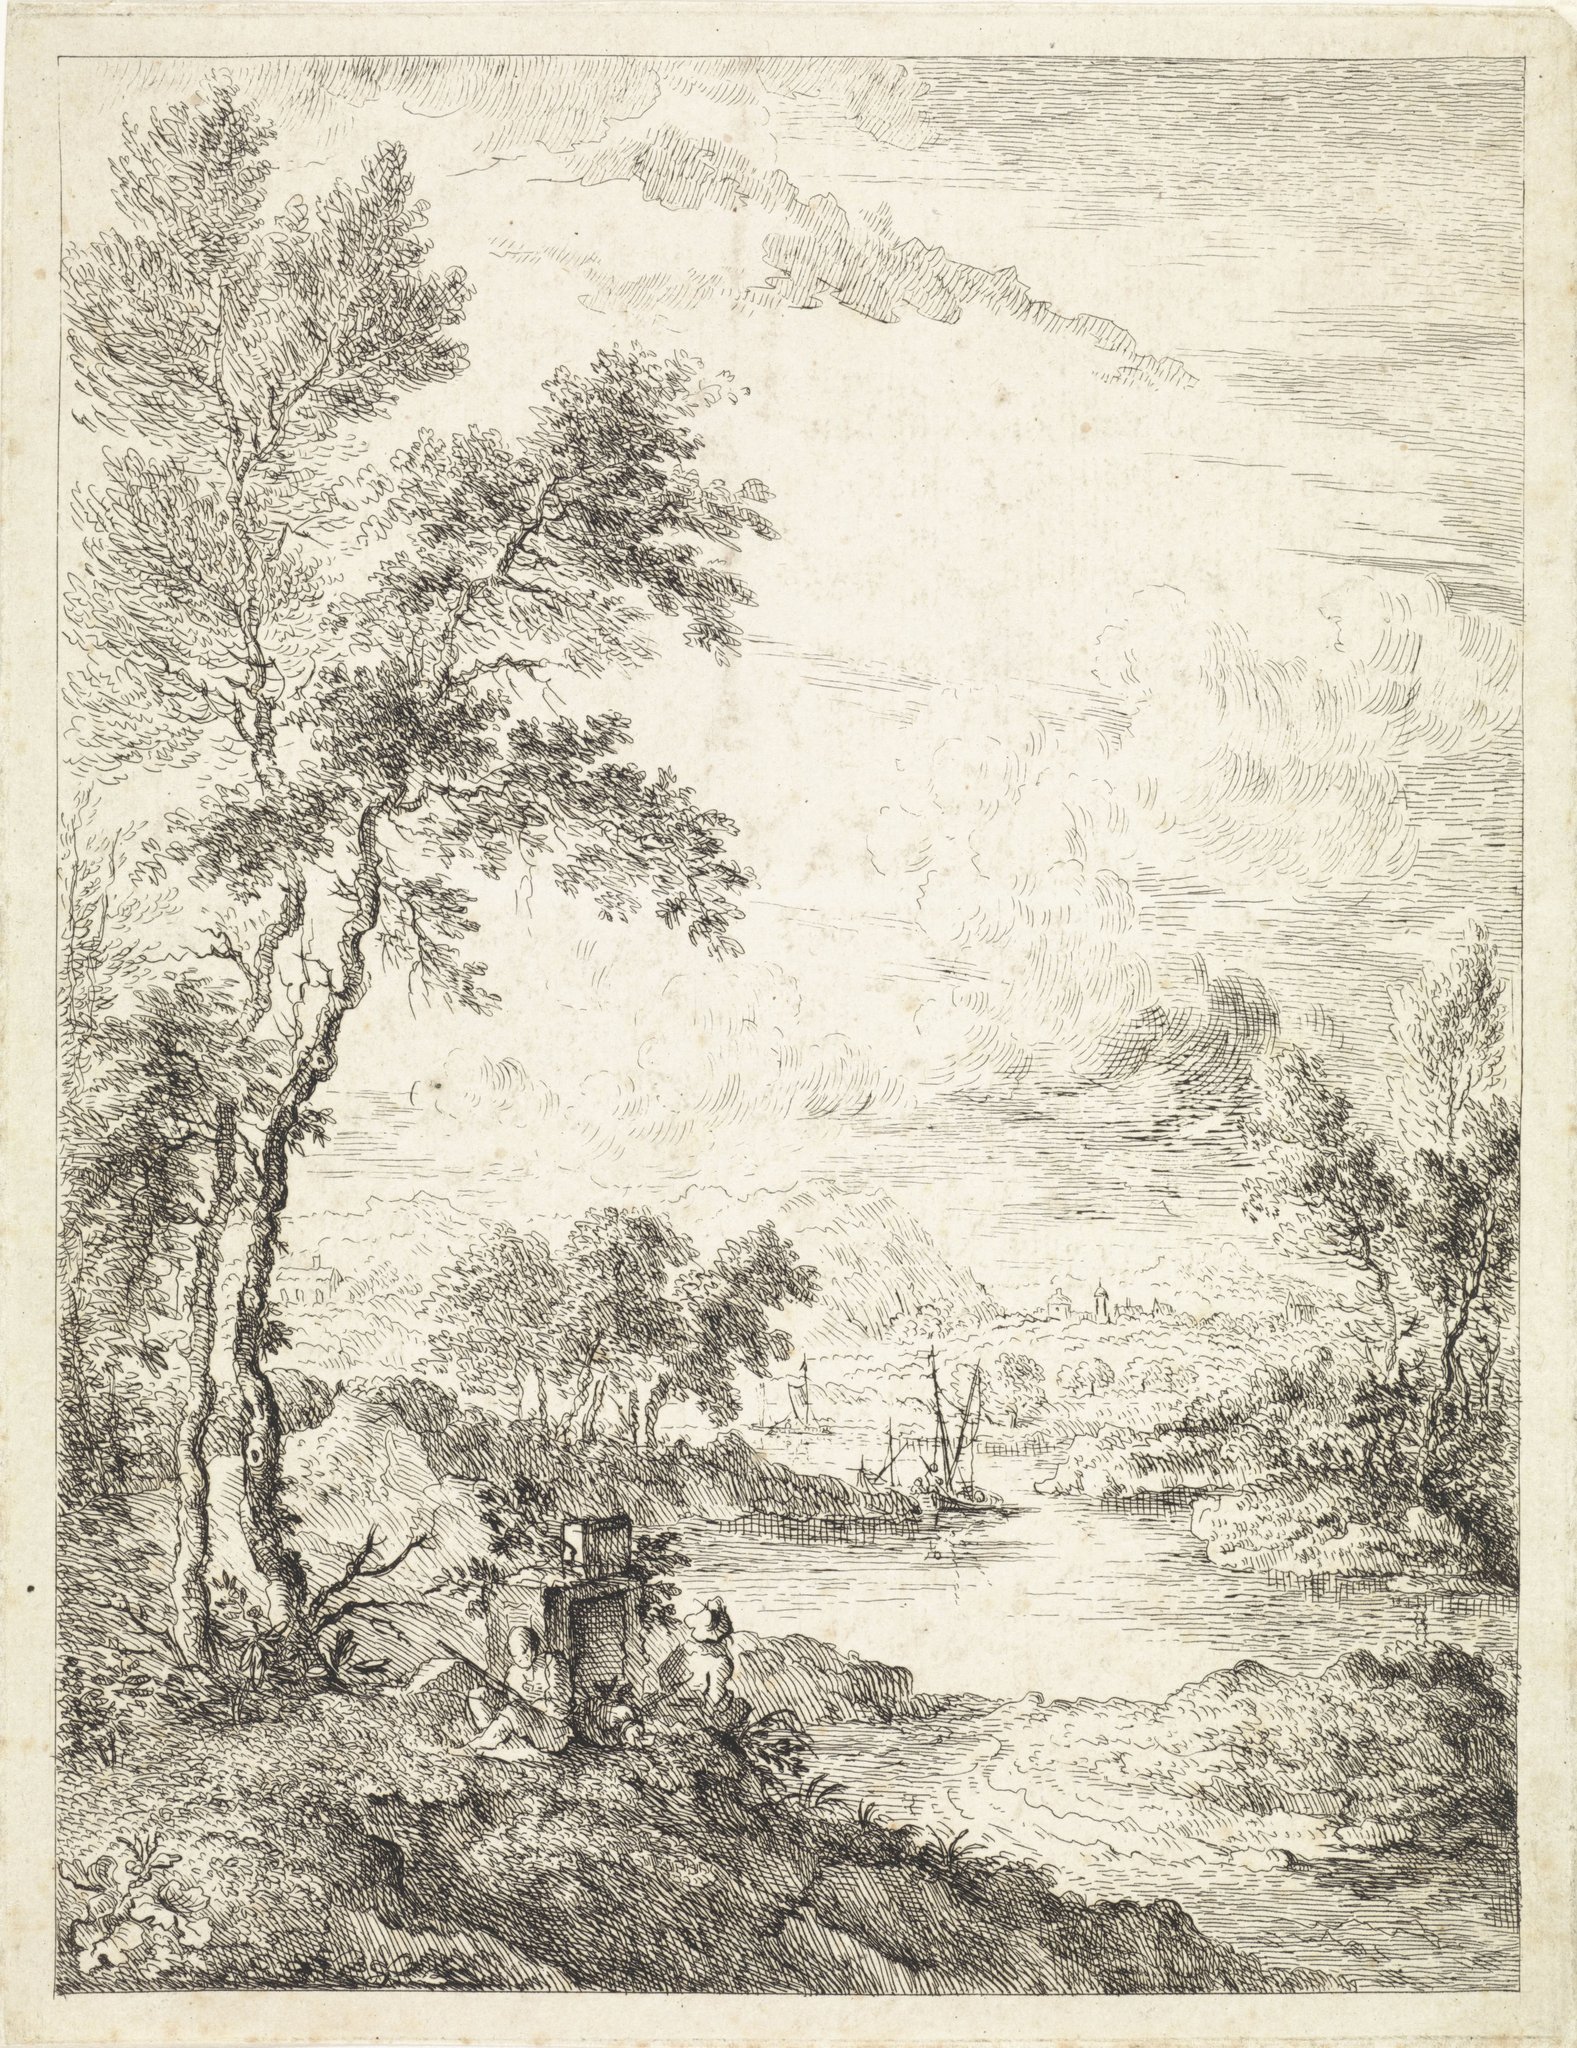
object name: print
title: Landschap met een rivier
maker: hendrik tavenier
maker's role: draughtsman, print maker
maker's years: 1734-1807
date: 1744-1807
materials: paper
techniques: etching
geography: haarlem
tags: river, landscapes (+ landscape with figures, staffage)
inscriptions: collector's mark: Lugt 2228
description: Landschap met rechts een rivier en links hoge bomen. Op de oever zitten twee mannen bij een brok steen.